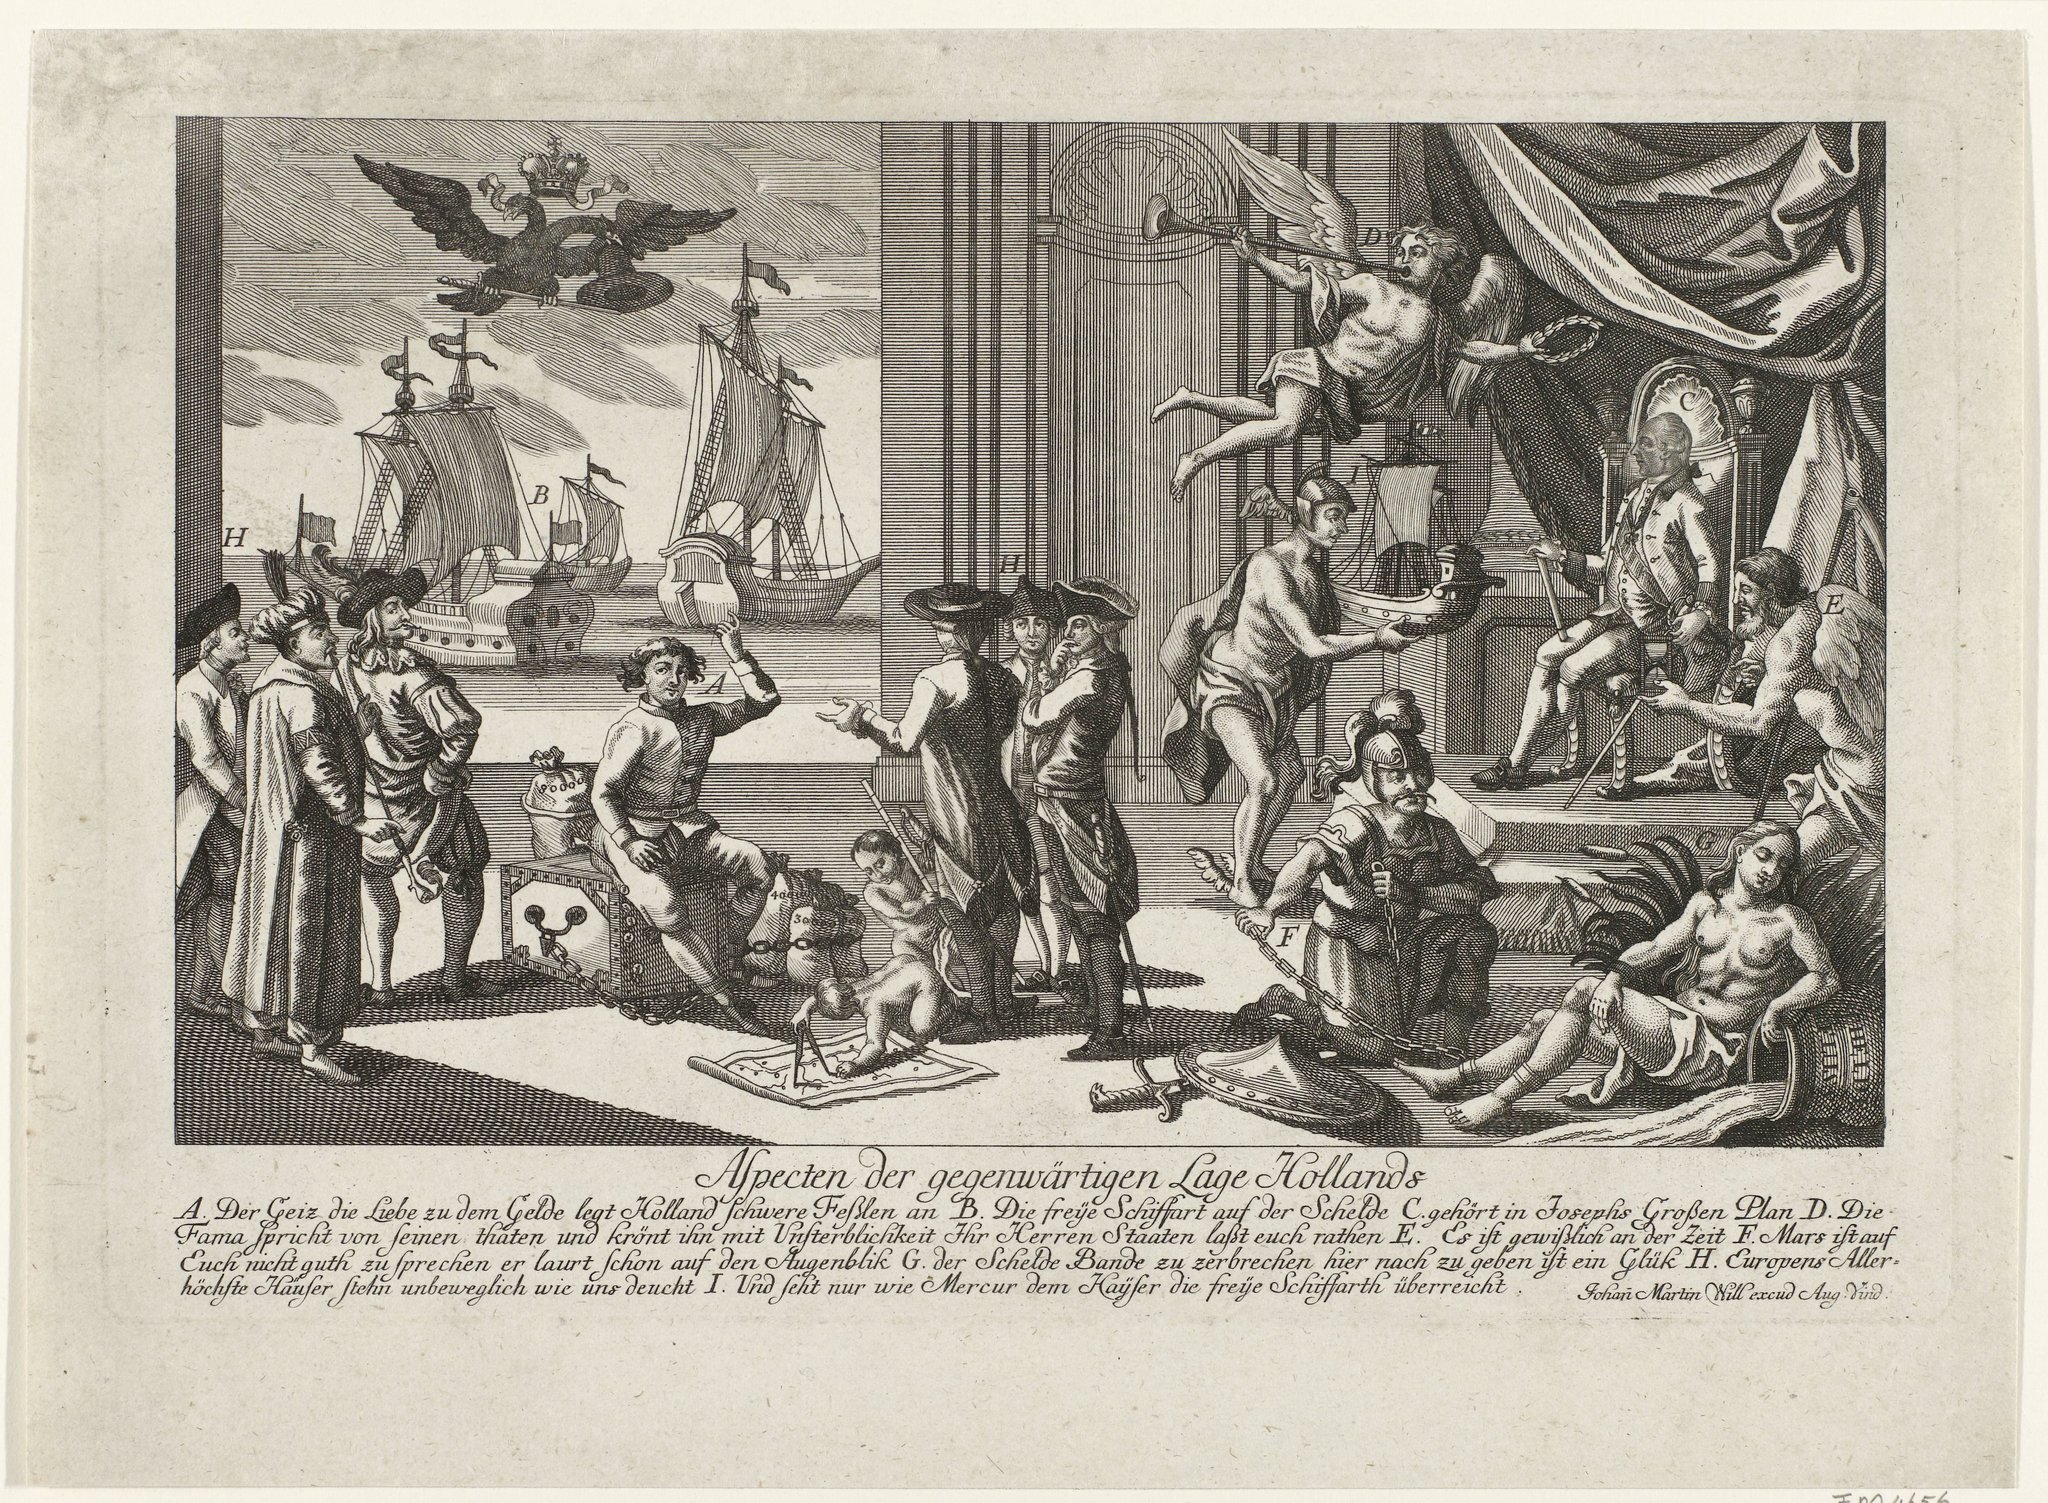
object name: cartoon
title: Spotprent op het Verdrag van Fontainebleau, 1785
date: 1785-1786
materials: paper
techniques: engraving, etching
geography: germany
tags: vienna, jozef ii (duits keizer)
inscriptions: collector's mark: Lugt 2228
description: Spotprent op de vrede gesloten te Parijs waarmee een eind kwam aan de Keteloorlog, de twisten tussen Nederland en de Oostenrijkse keizer Jozef II, 8 november 1785. Nederland betaalde 8,5 miljoen gulden en accepteerde andere vernederende voorwaarden. De Nederlander zit geketend op een geldkist, rechts aanvaardt keizer Jozef II op zijn troon een schip van Mercurius. Op de achtergrond de vrije scheepvaart op de Schelde, rechtsvoor ontdoet Mars de riviermaagd van de Schelde van haar ketenen. Vertegenwoordigers van andere Europese landen kijken toe zonder in te grijpen. In het onderschrift de legenda A-I in het Duits.